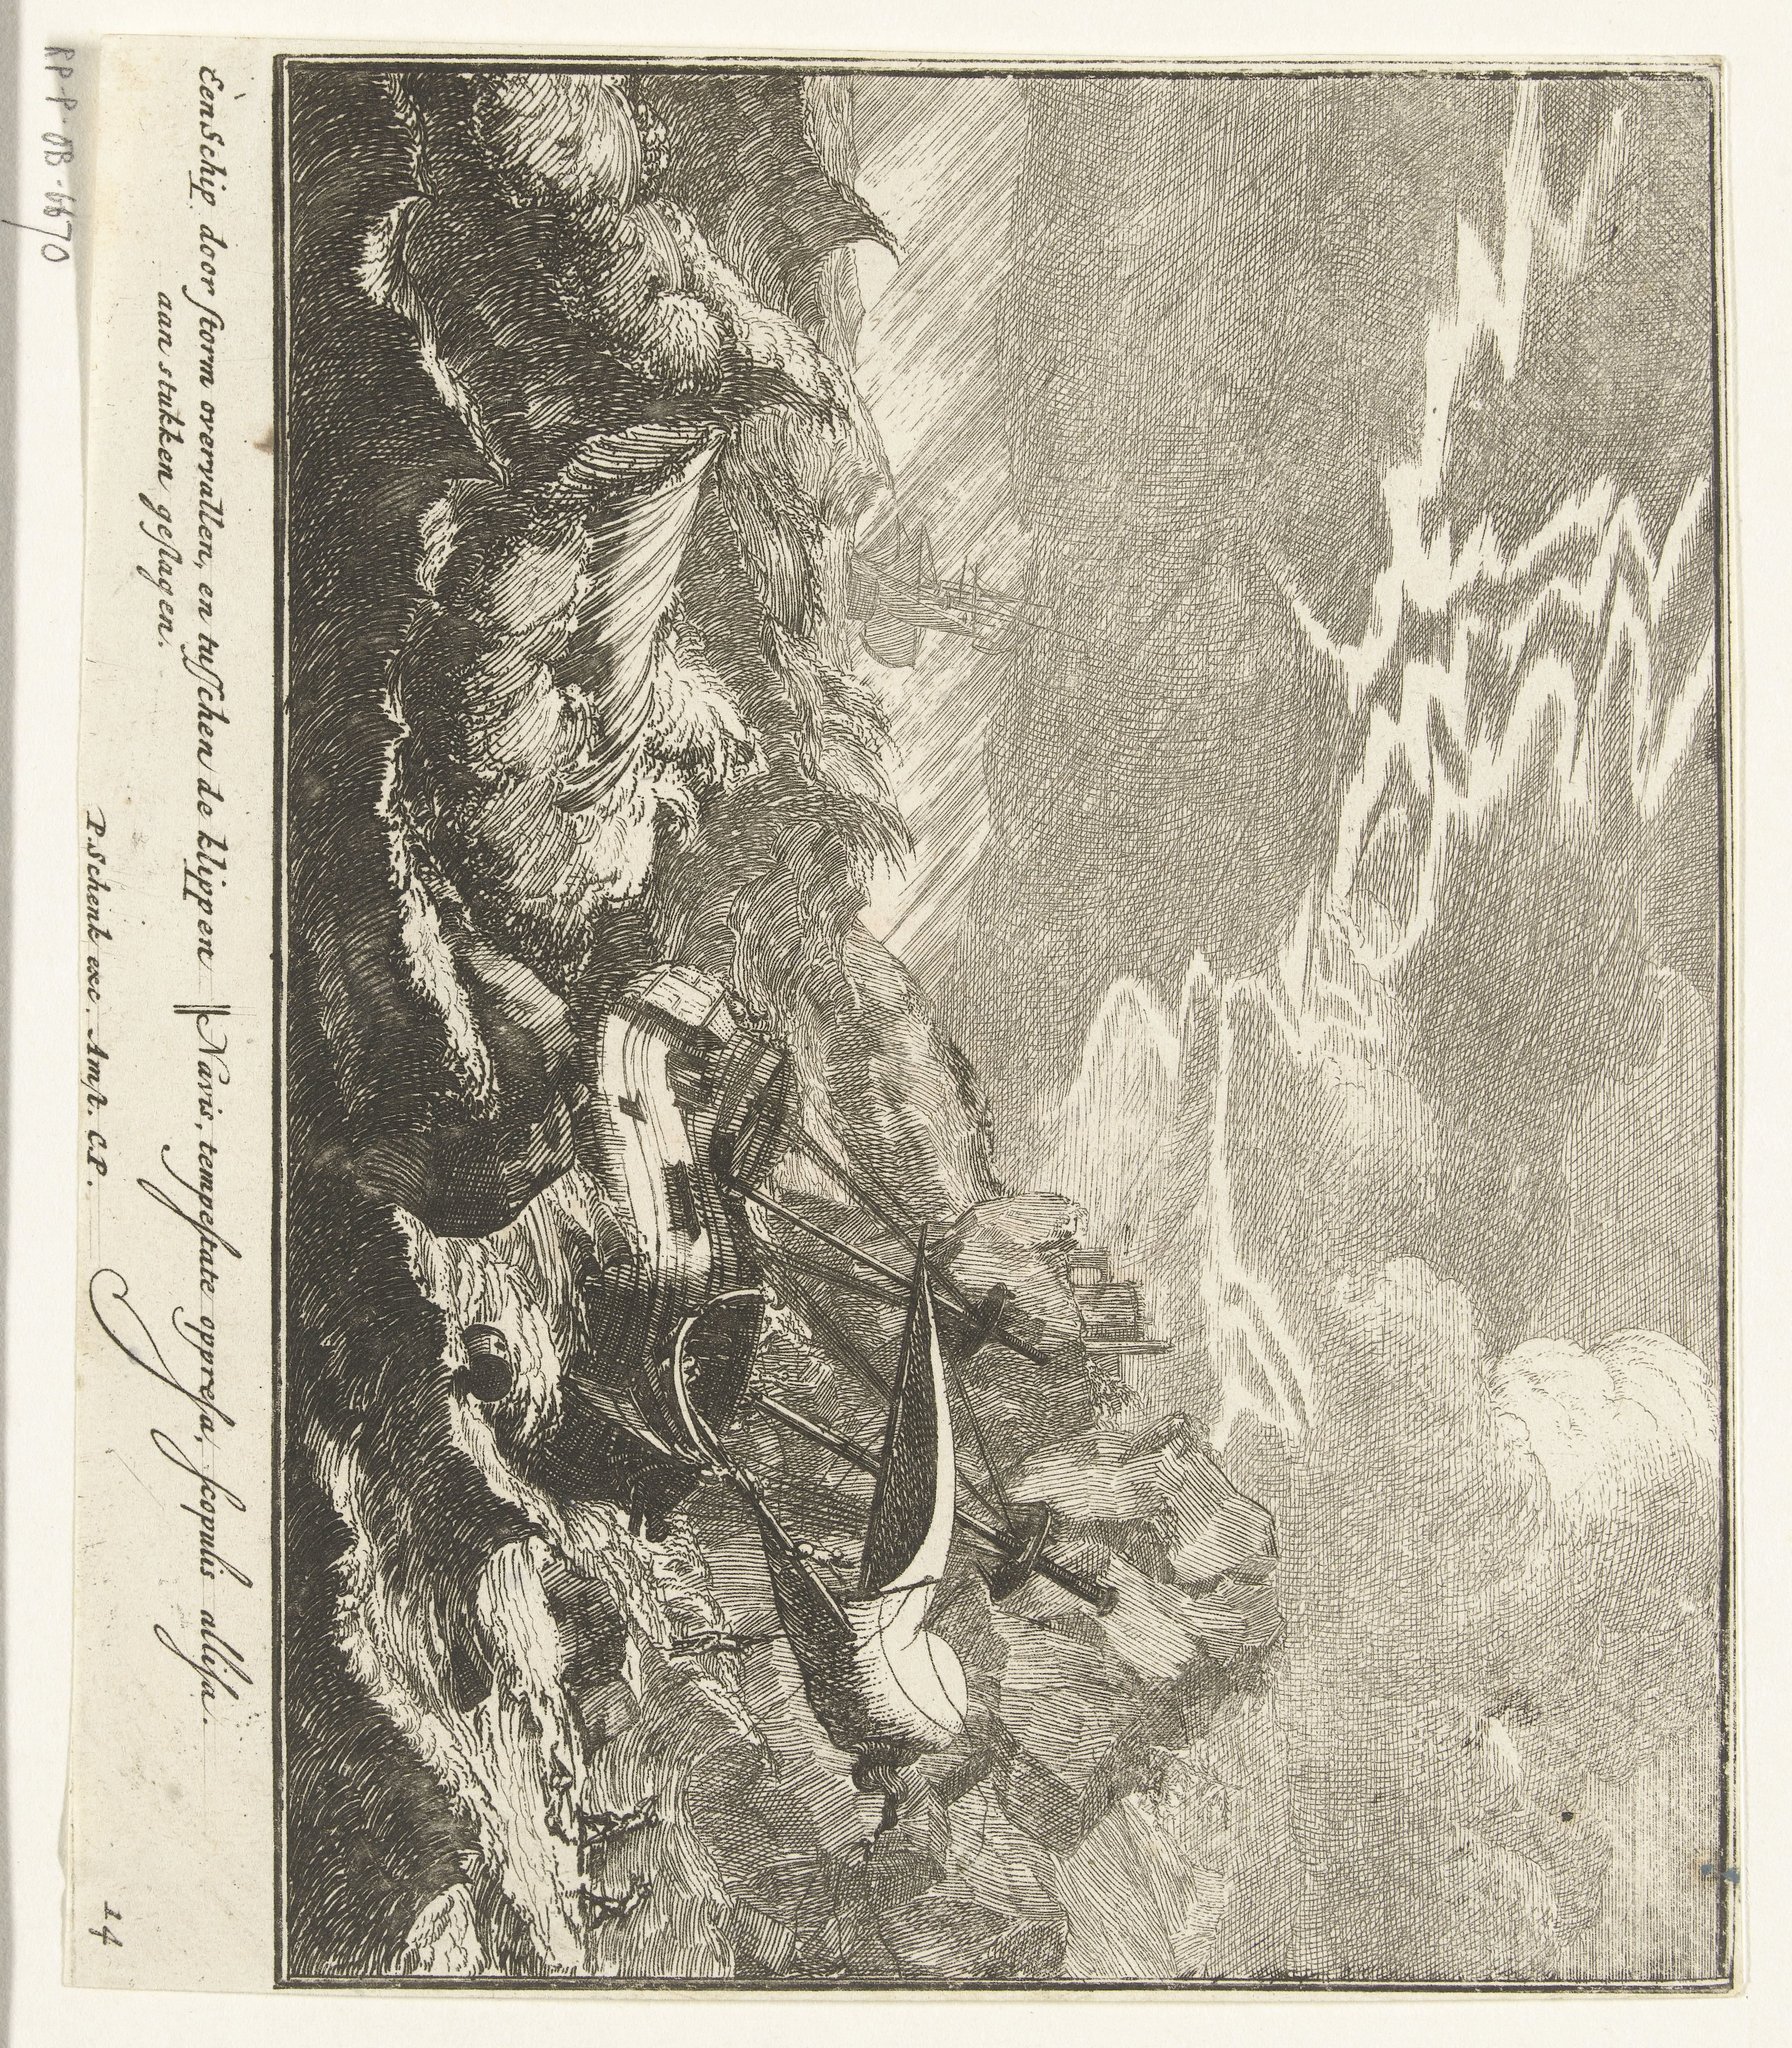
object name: print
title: Een schip slaat tijdens een storm te pletter op de rotsen, plaat nr. 14, ca. 1700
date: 1690-1710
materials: paper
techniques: etching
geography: northern netherlands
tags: shipwreck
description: Een schip slaat tijdens een storm te pletter op de rotsen voor de kust. No. 14 uit serie van 16 prenten waarop de bouw en lotgevallen van een schip zijn afgebeeld. Met onderschriften in het Nederlands en Latijn.